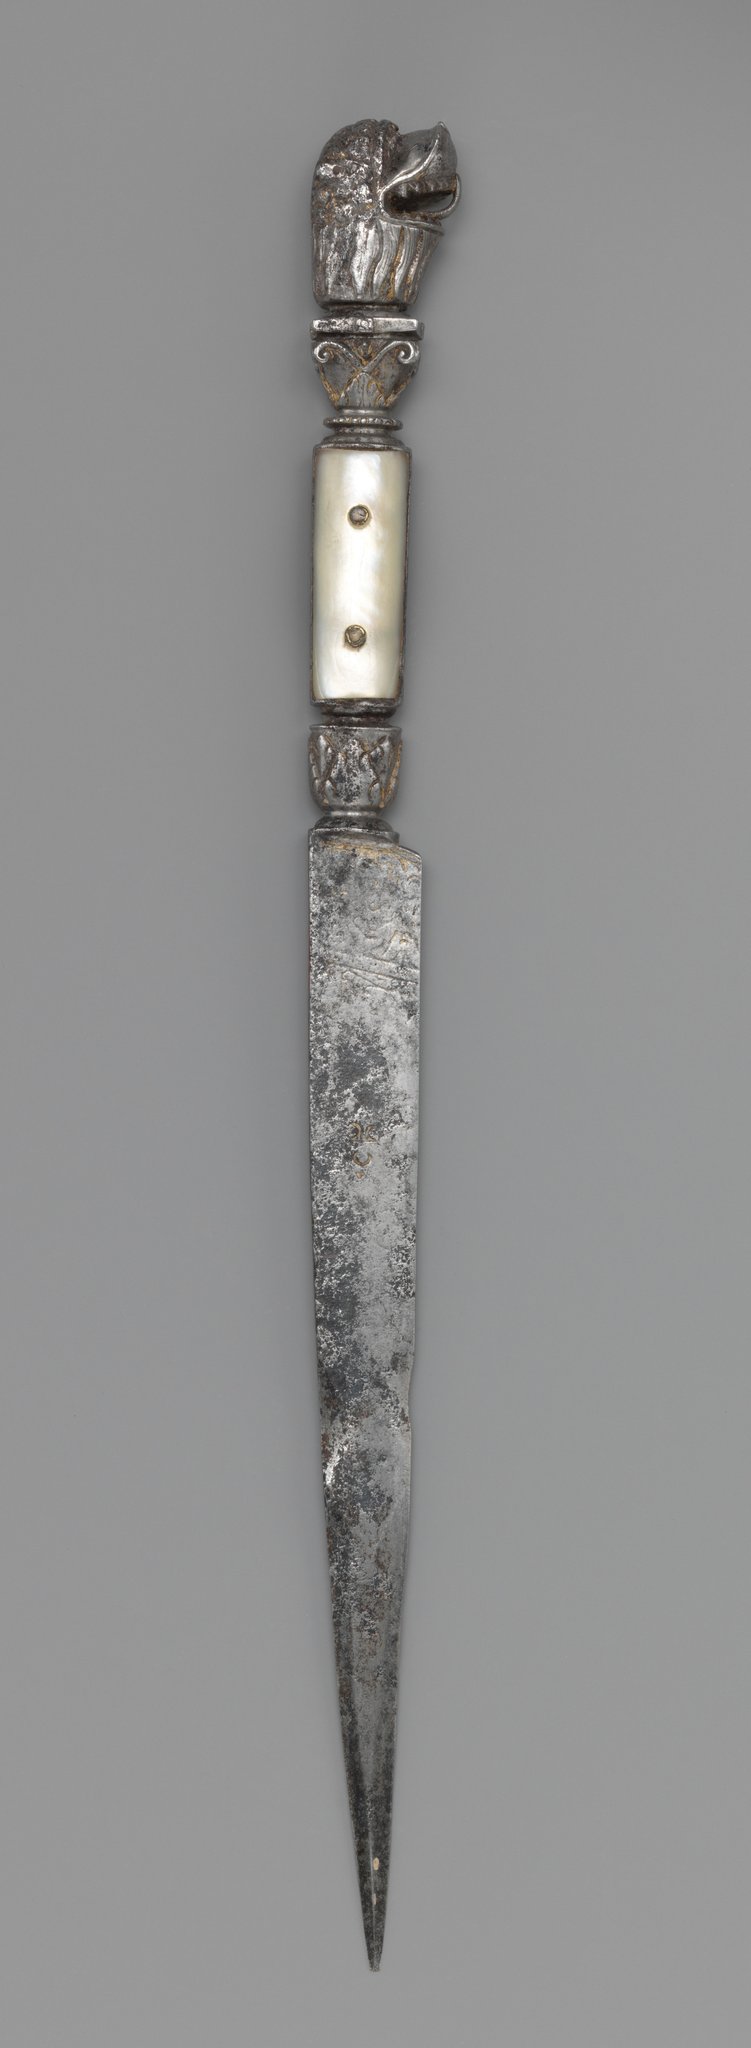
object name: table knife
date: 1501-1600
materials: mother of pearl, silver, steel